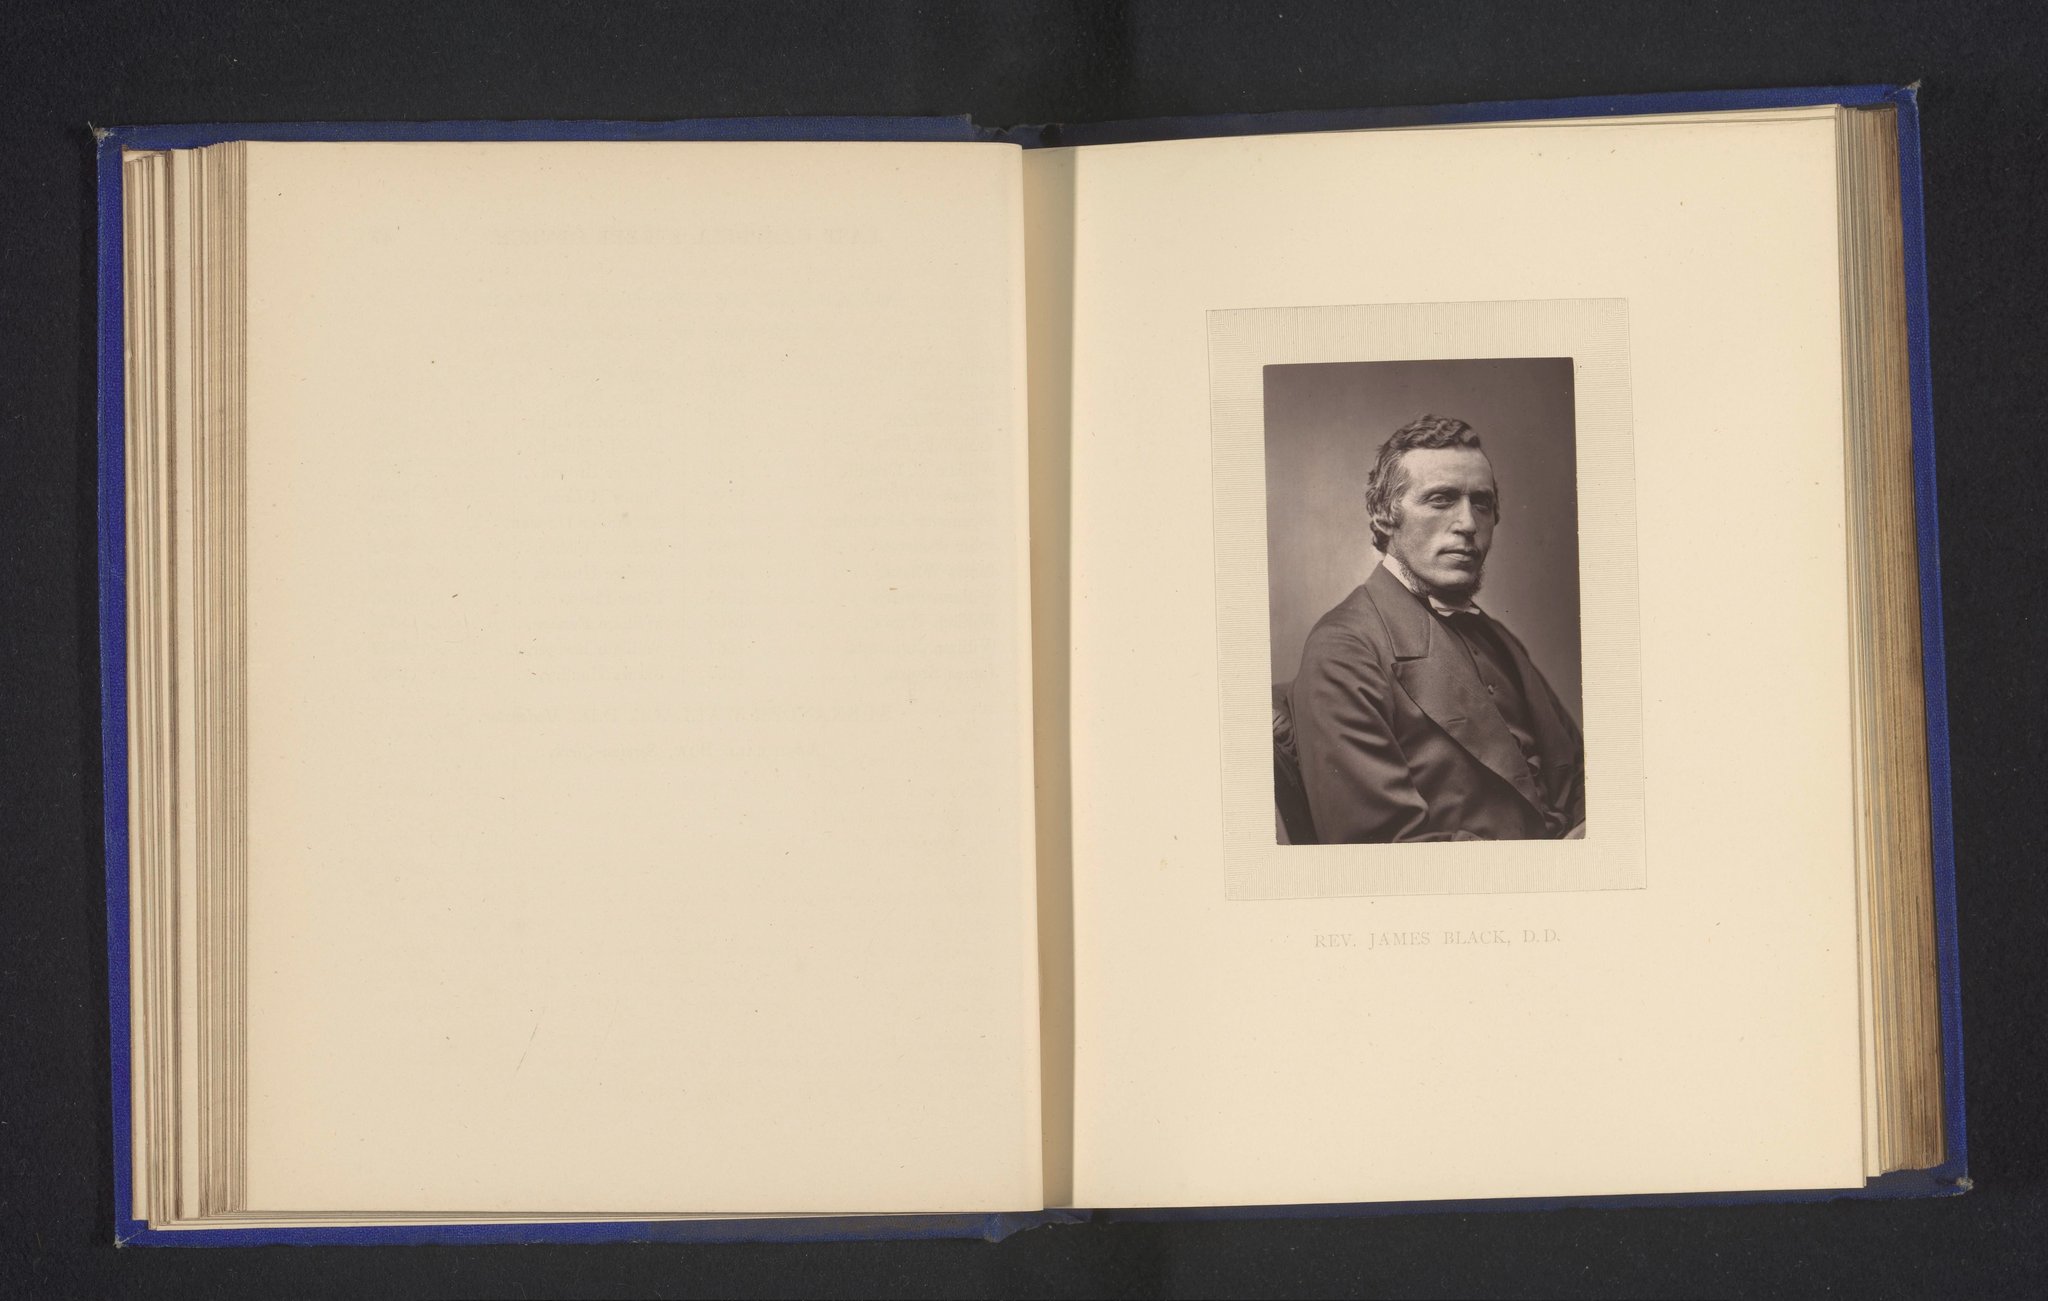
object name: photomechanical print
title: Portret van James Black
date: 1865-1875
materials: paper, photographic support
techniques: carbon print, woodburytype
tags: functionaries and dignitaries (with name) ~ protestant churches